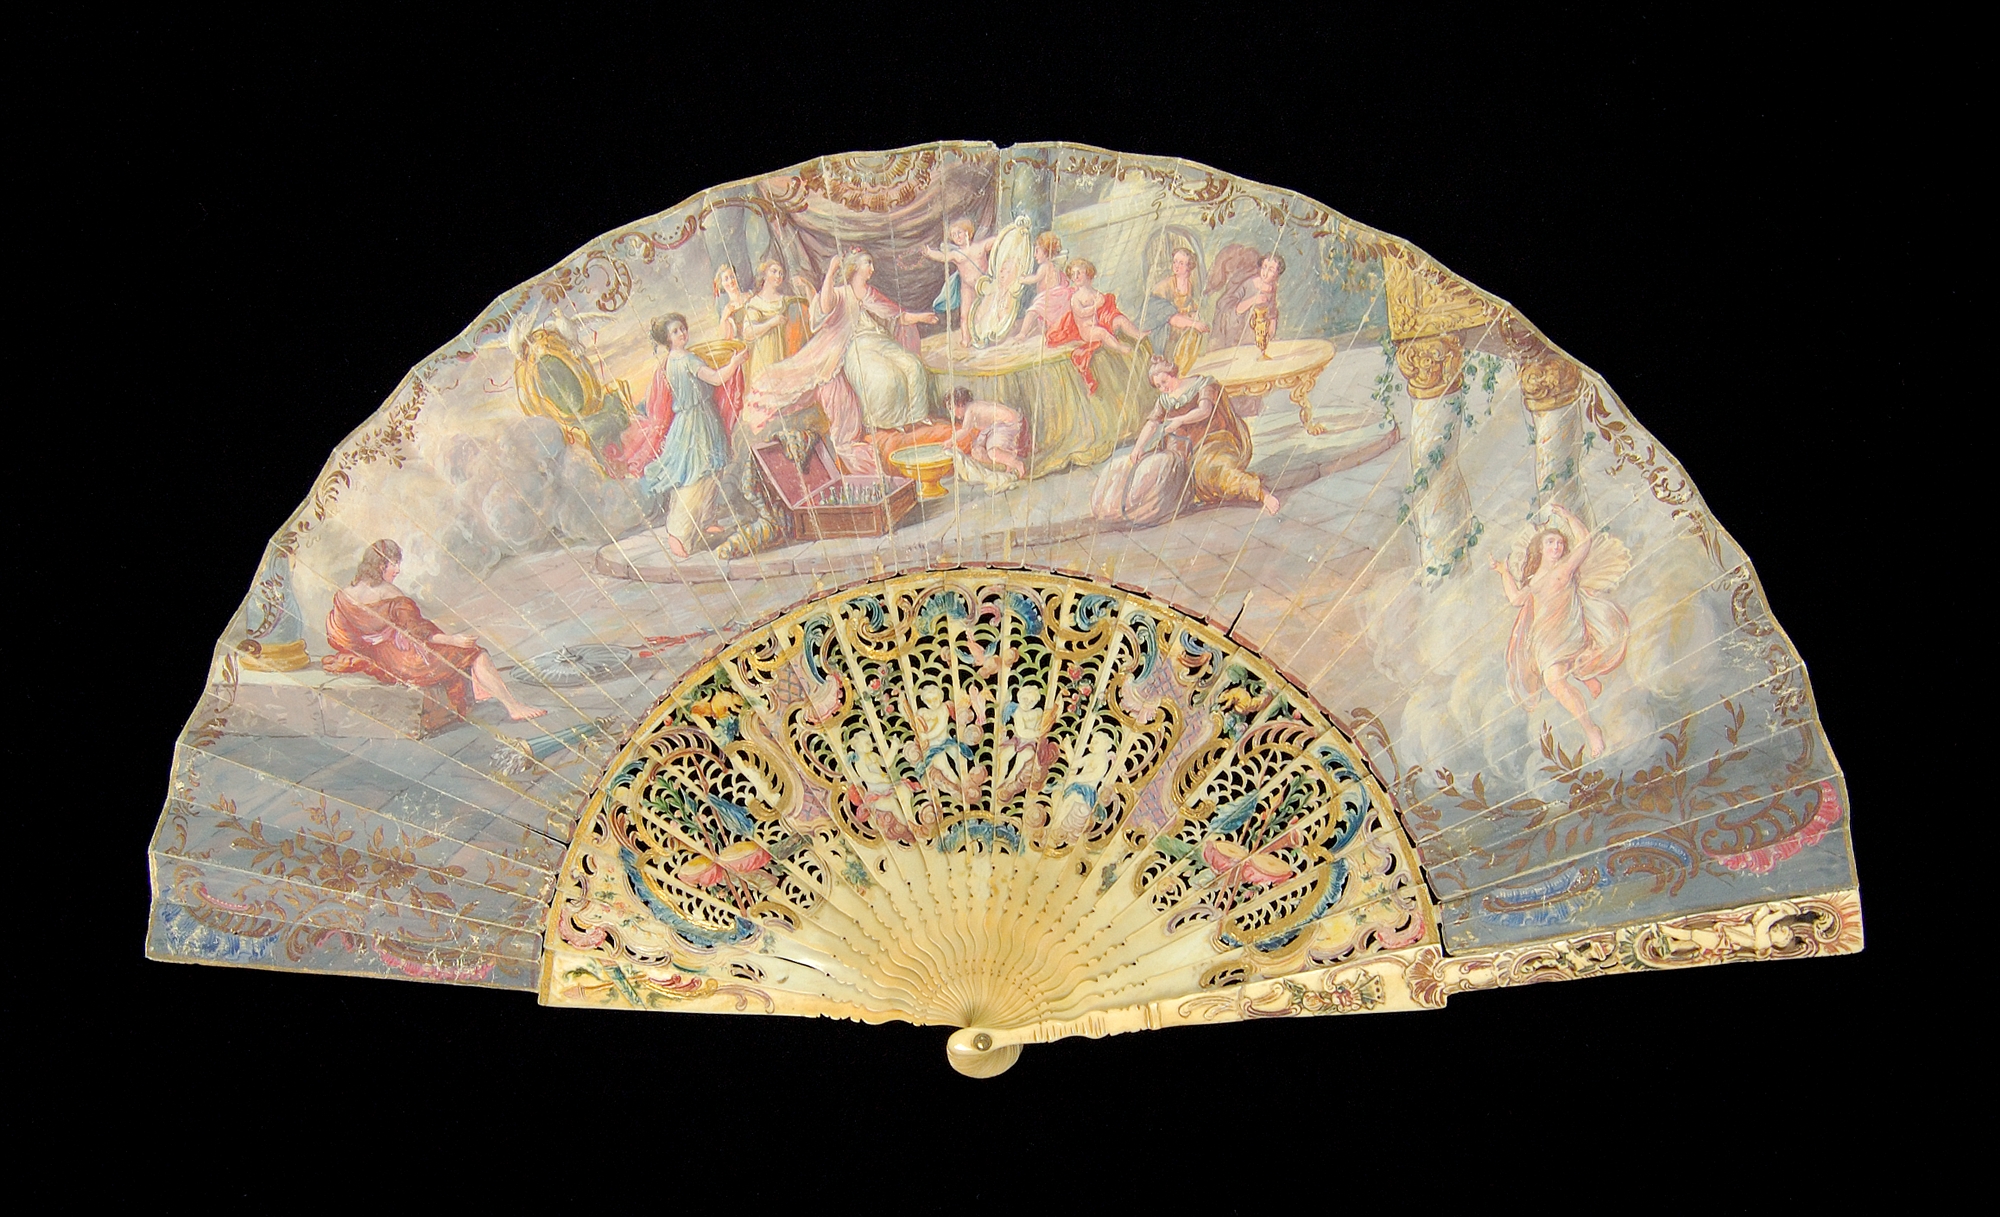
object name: fan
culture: european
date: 1776-1800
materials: ivory, paper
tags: children,women,putti